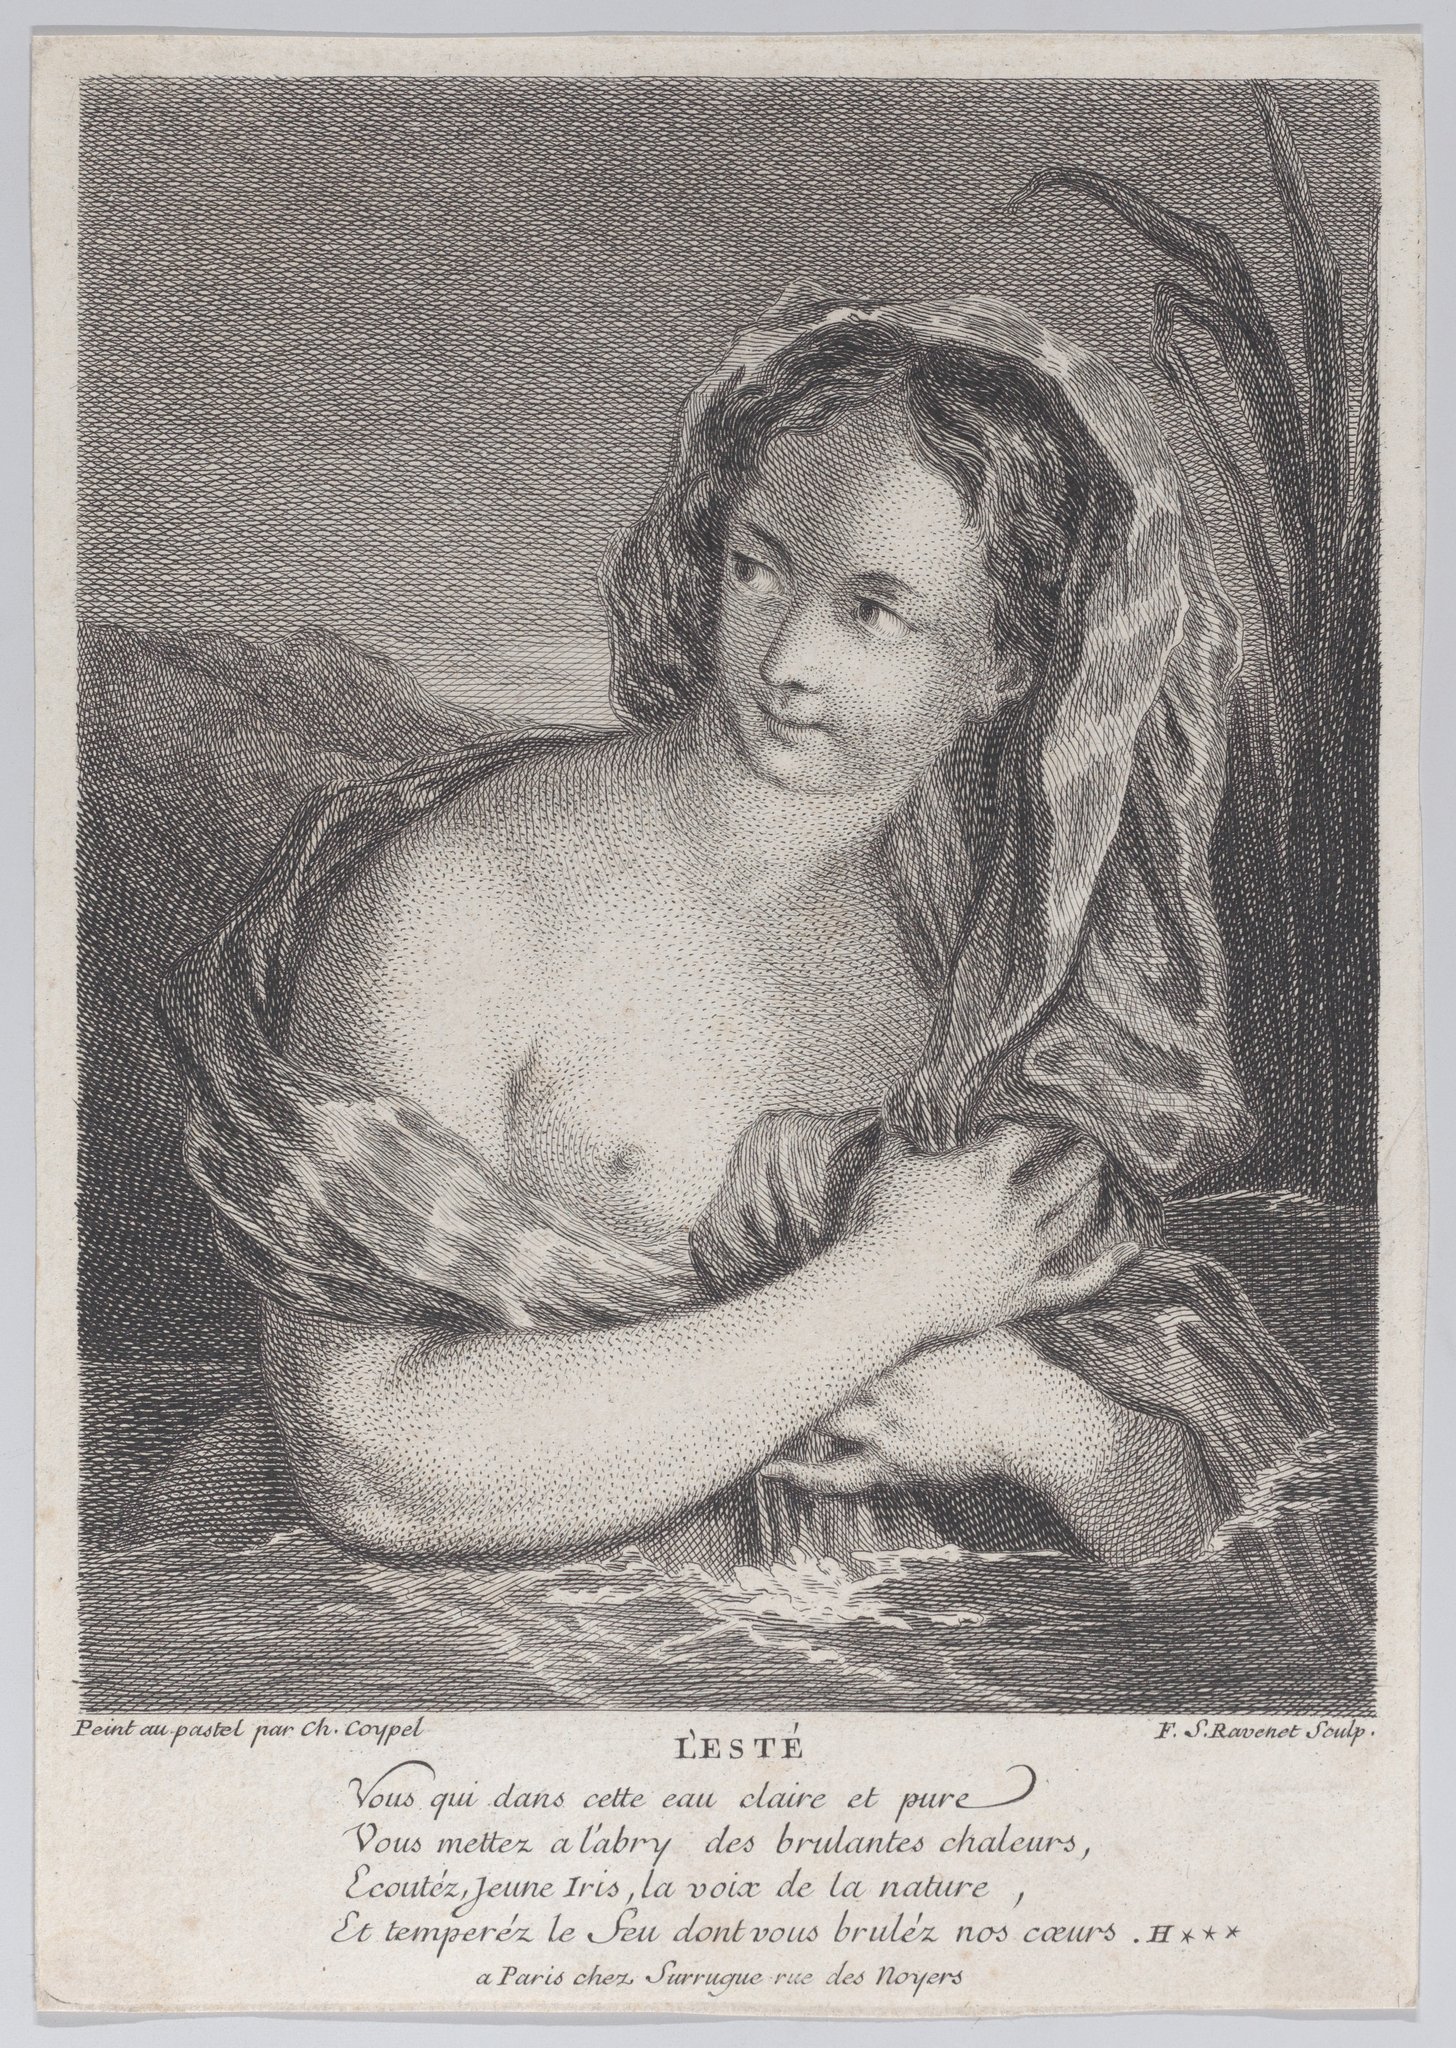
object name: print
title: Summer (L'Esté)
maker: simon francis ravenet, the elder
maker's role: artist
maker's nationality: french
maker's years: 1706-1774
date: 1742-1762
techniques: engraving, etching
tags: female nudes